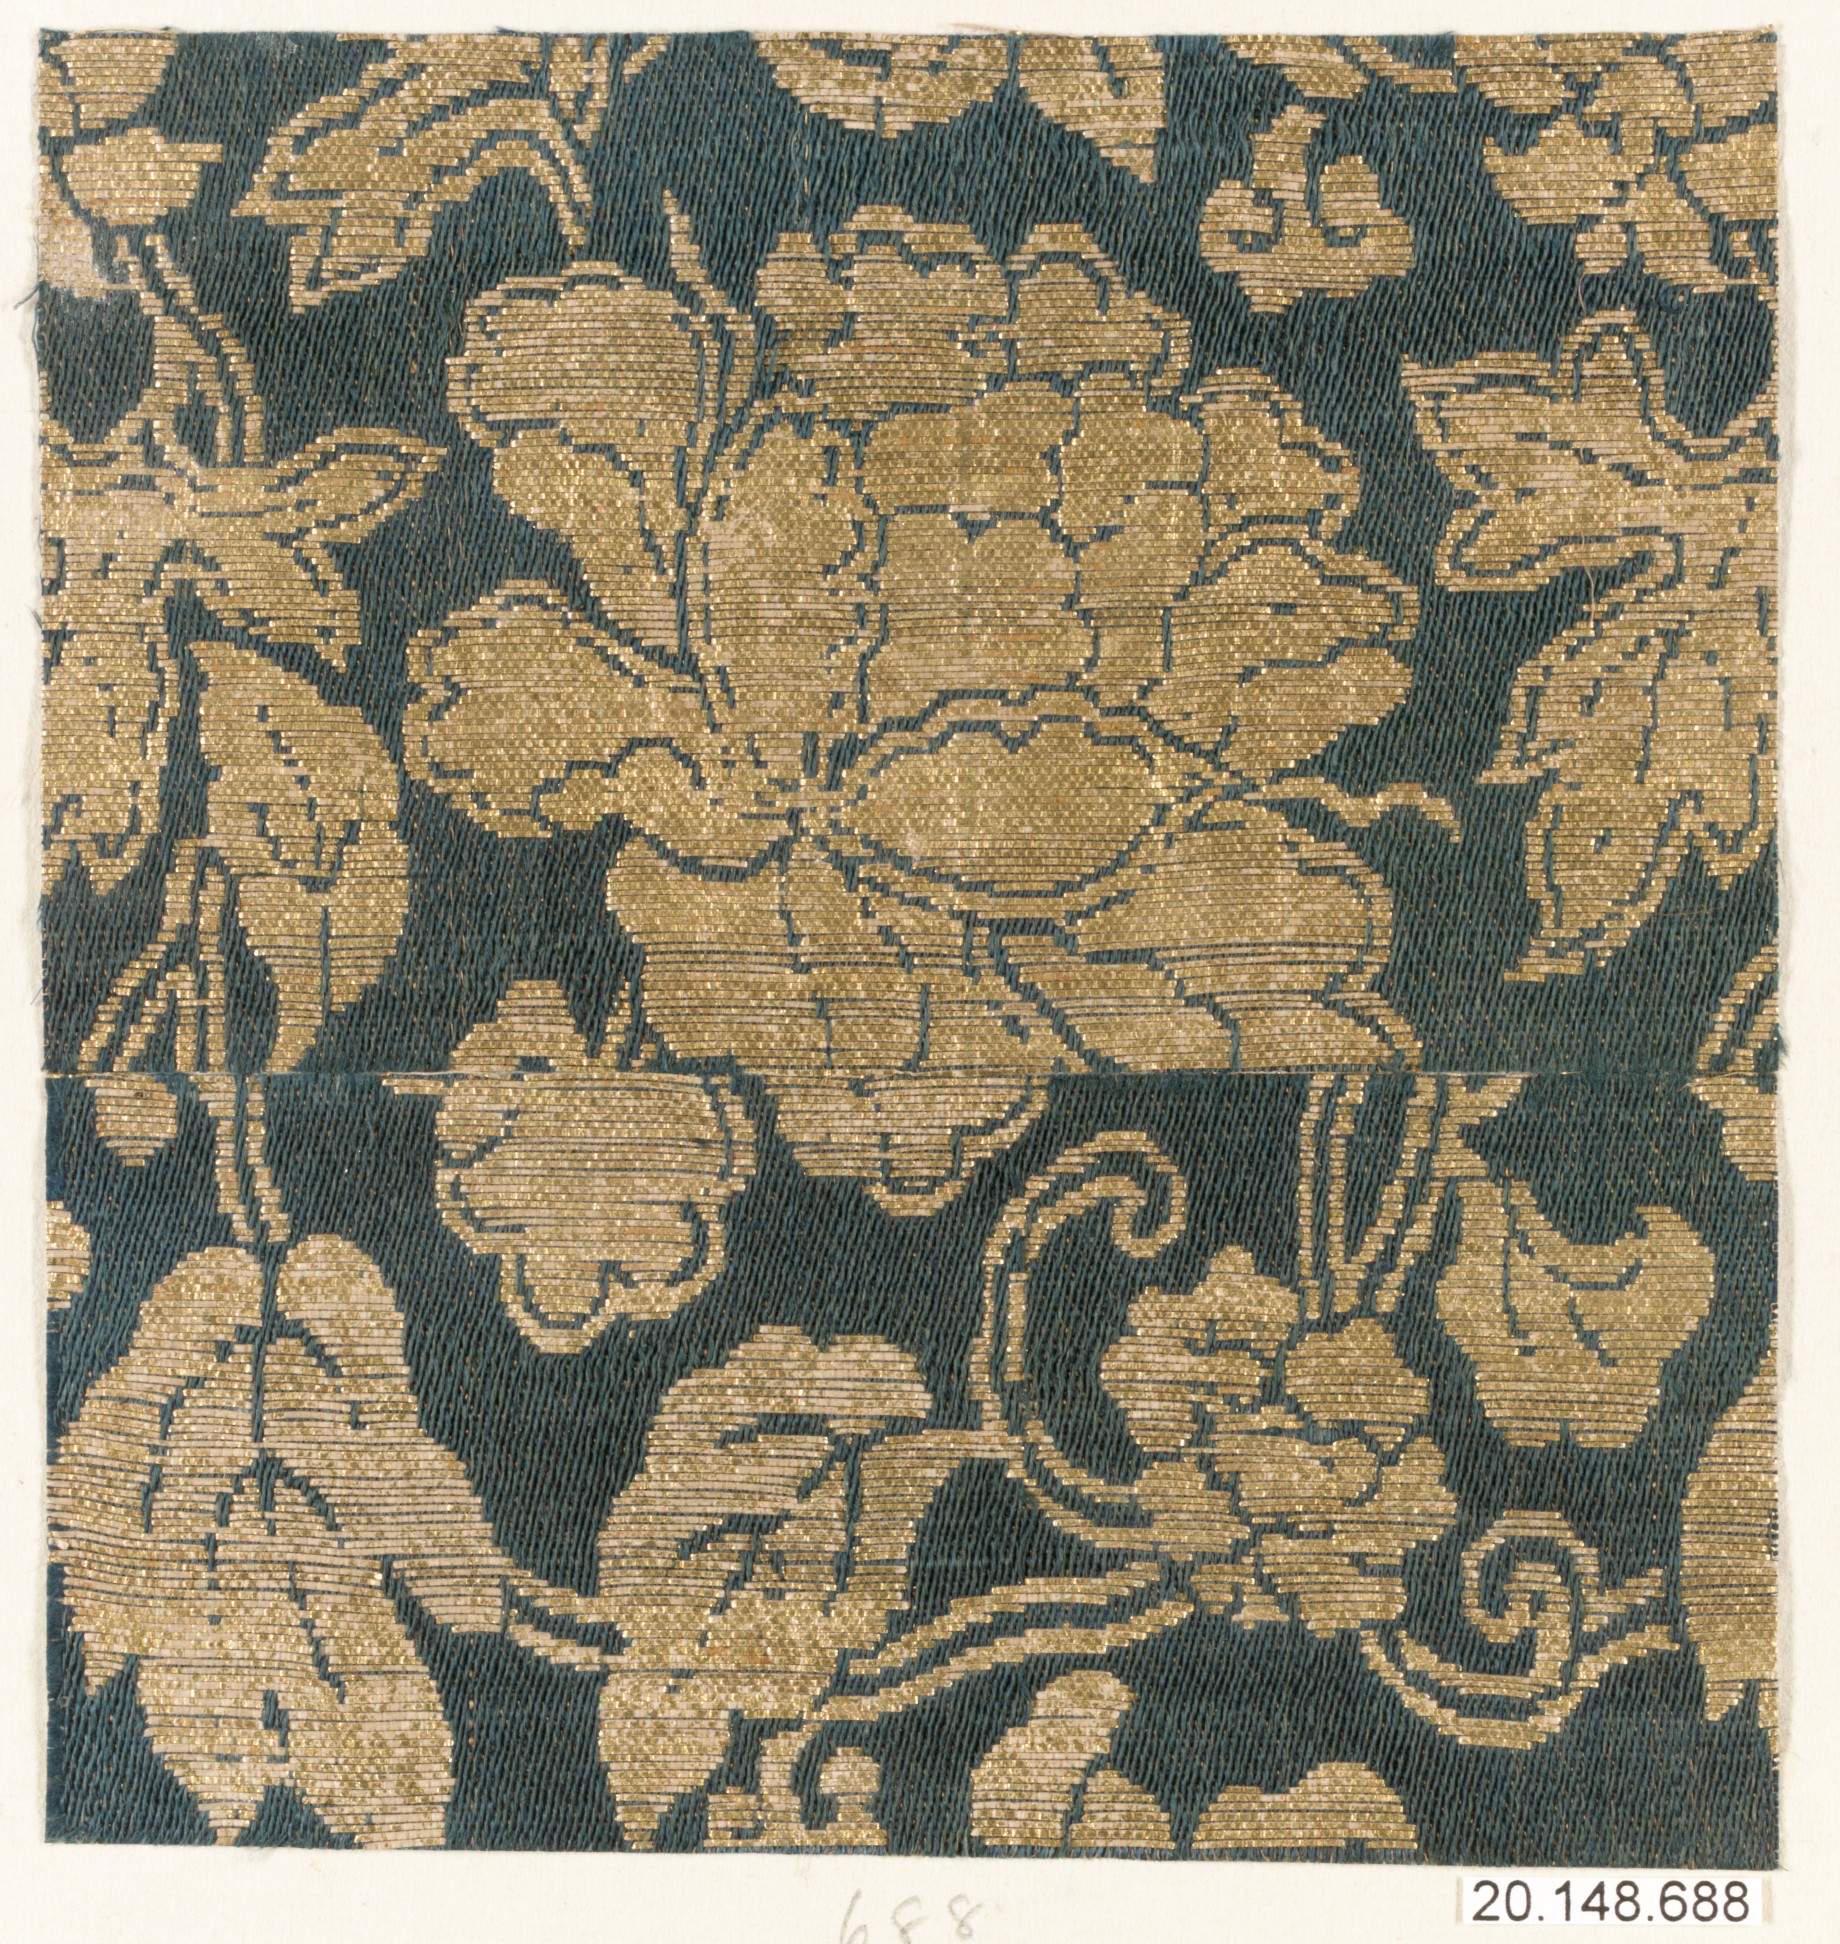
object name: piece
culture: japanese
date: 1701-1800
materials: silk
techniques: compound weave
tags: flowers,leaves